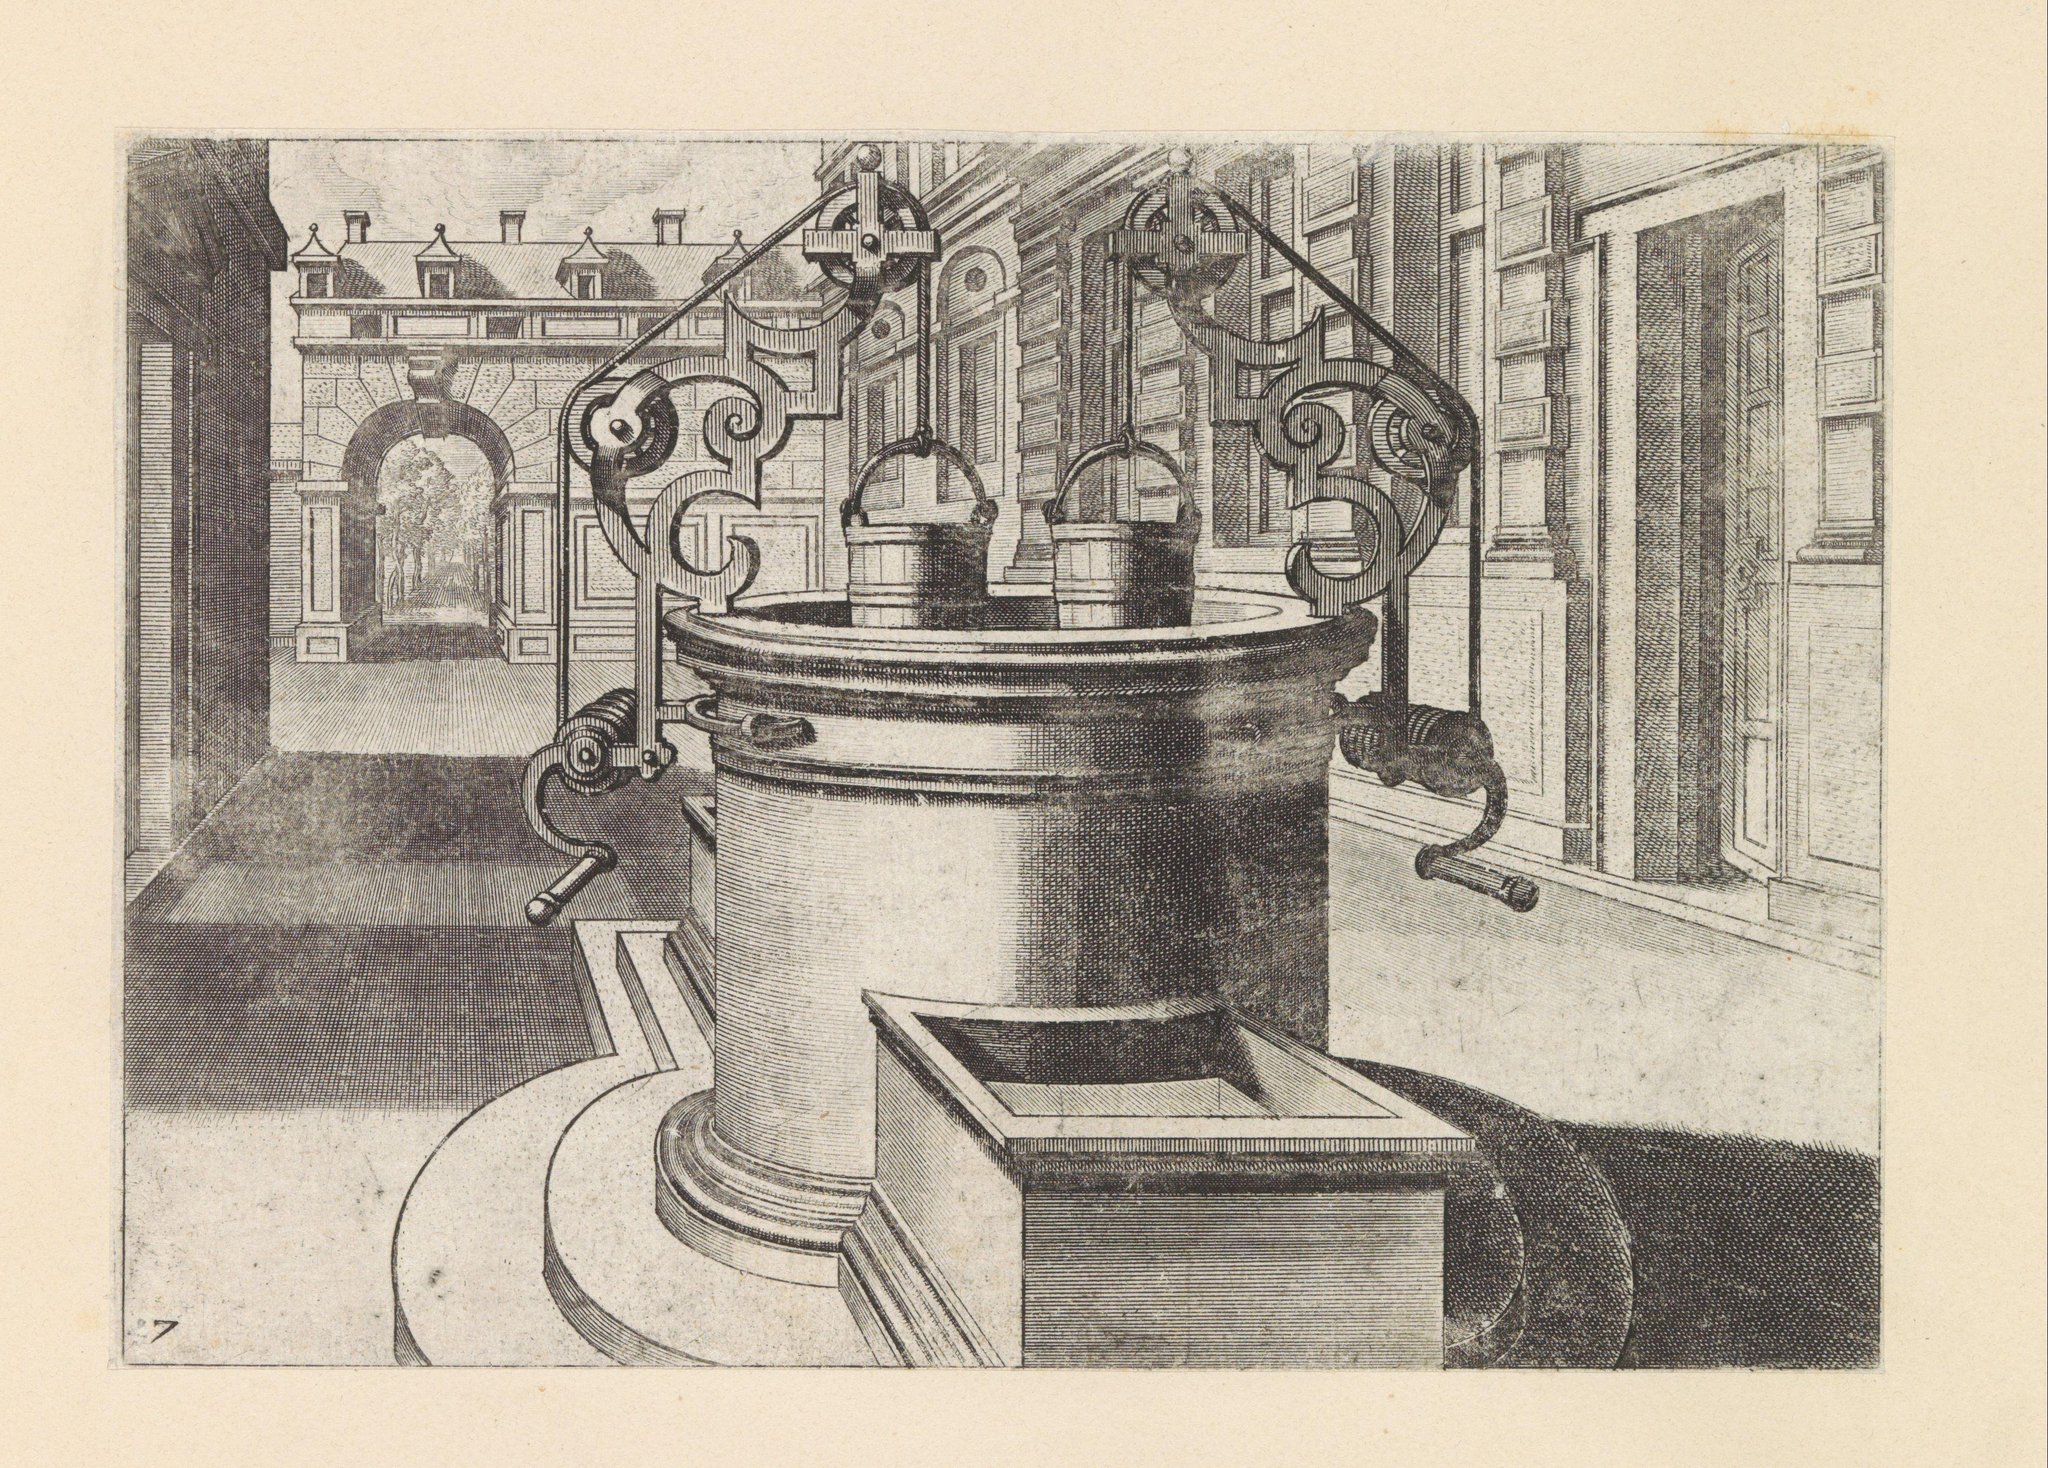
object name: album leaf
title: Waterputten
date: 1574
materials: paper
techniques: etching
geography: antwerp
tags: well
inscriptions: inscription: ‘2’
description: Een straat met een ronde put tussen twee rechthoekige bassins op een verhoging. Boven de put hangen twee akers, die elk via twee katrollen aan een lier bevestigd zijn. De prent maakt deel uit van een album.